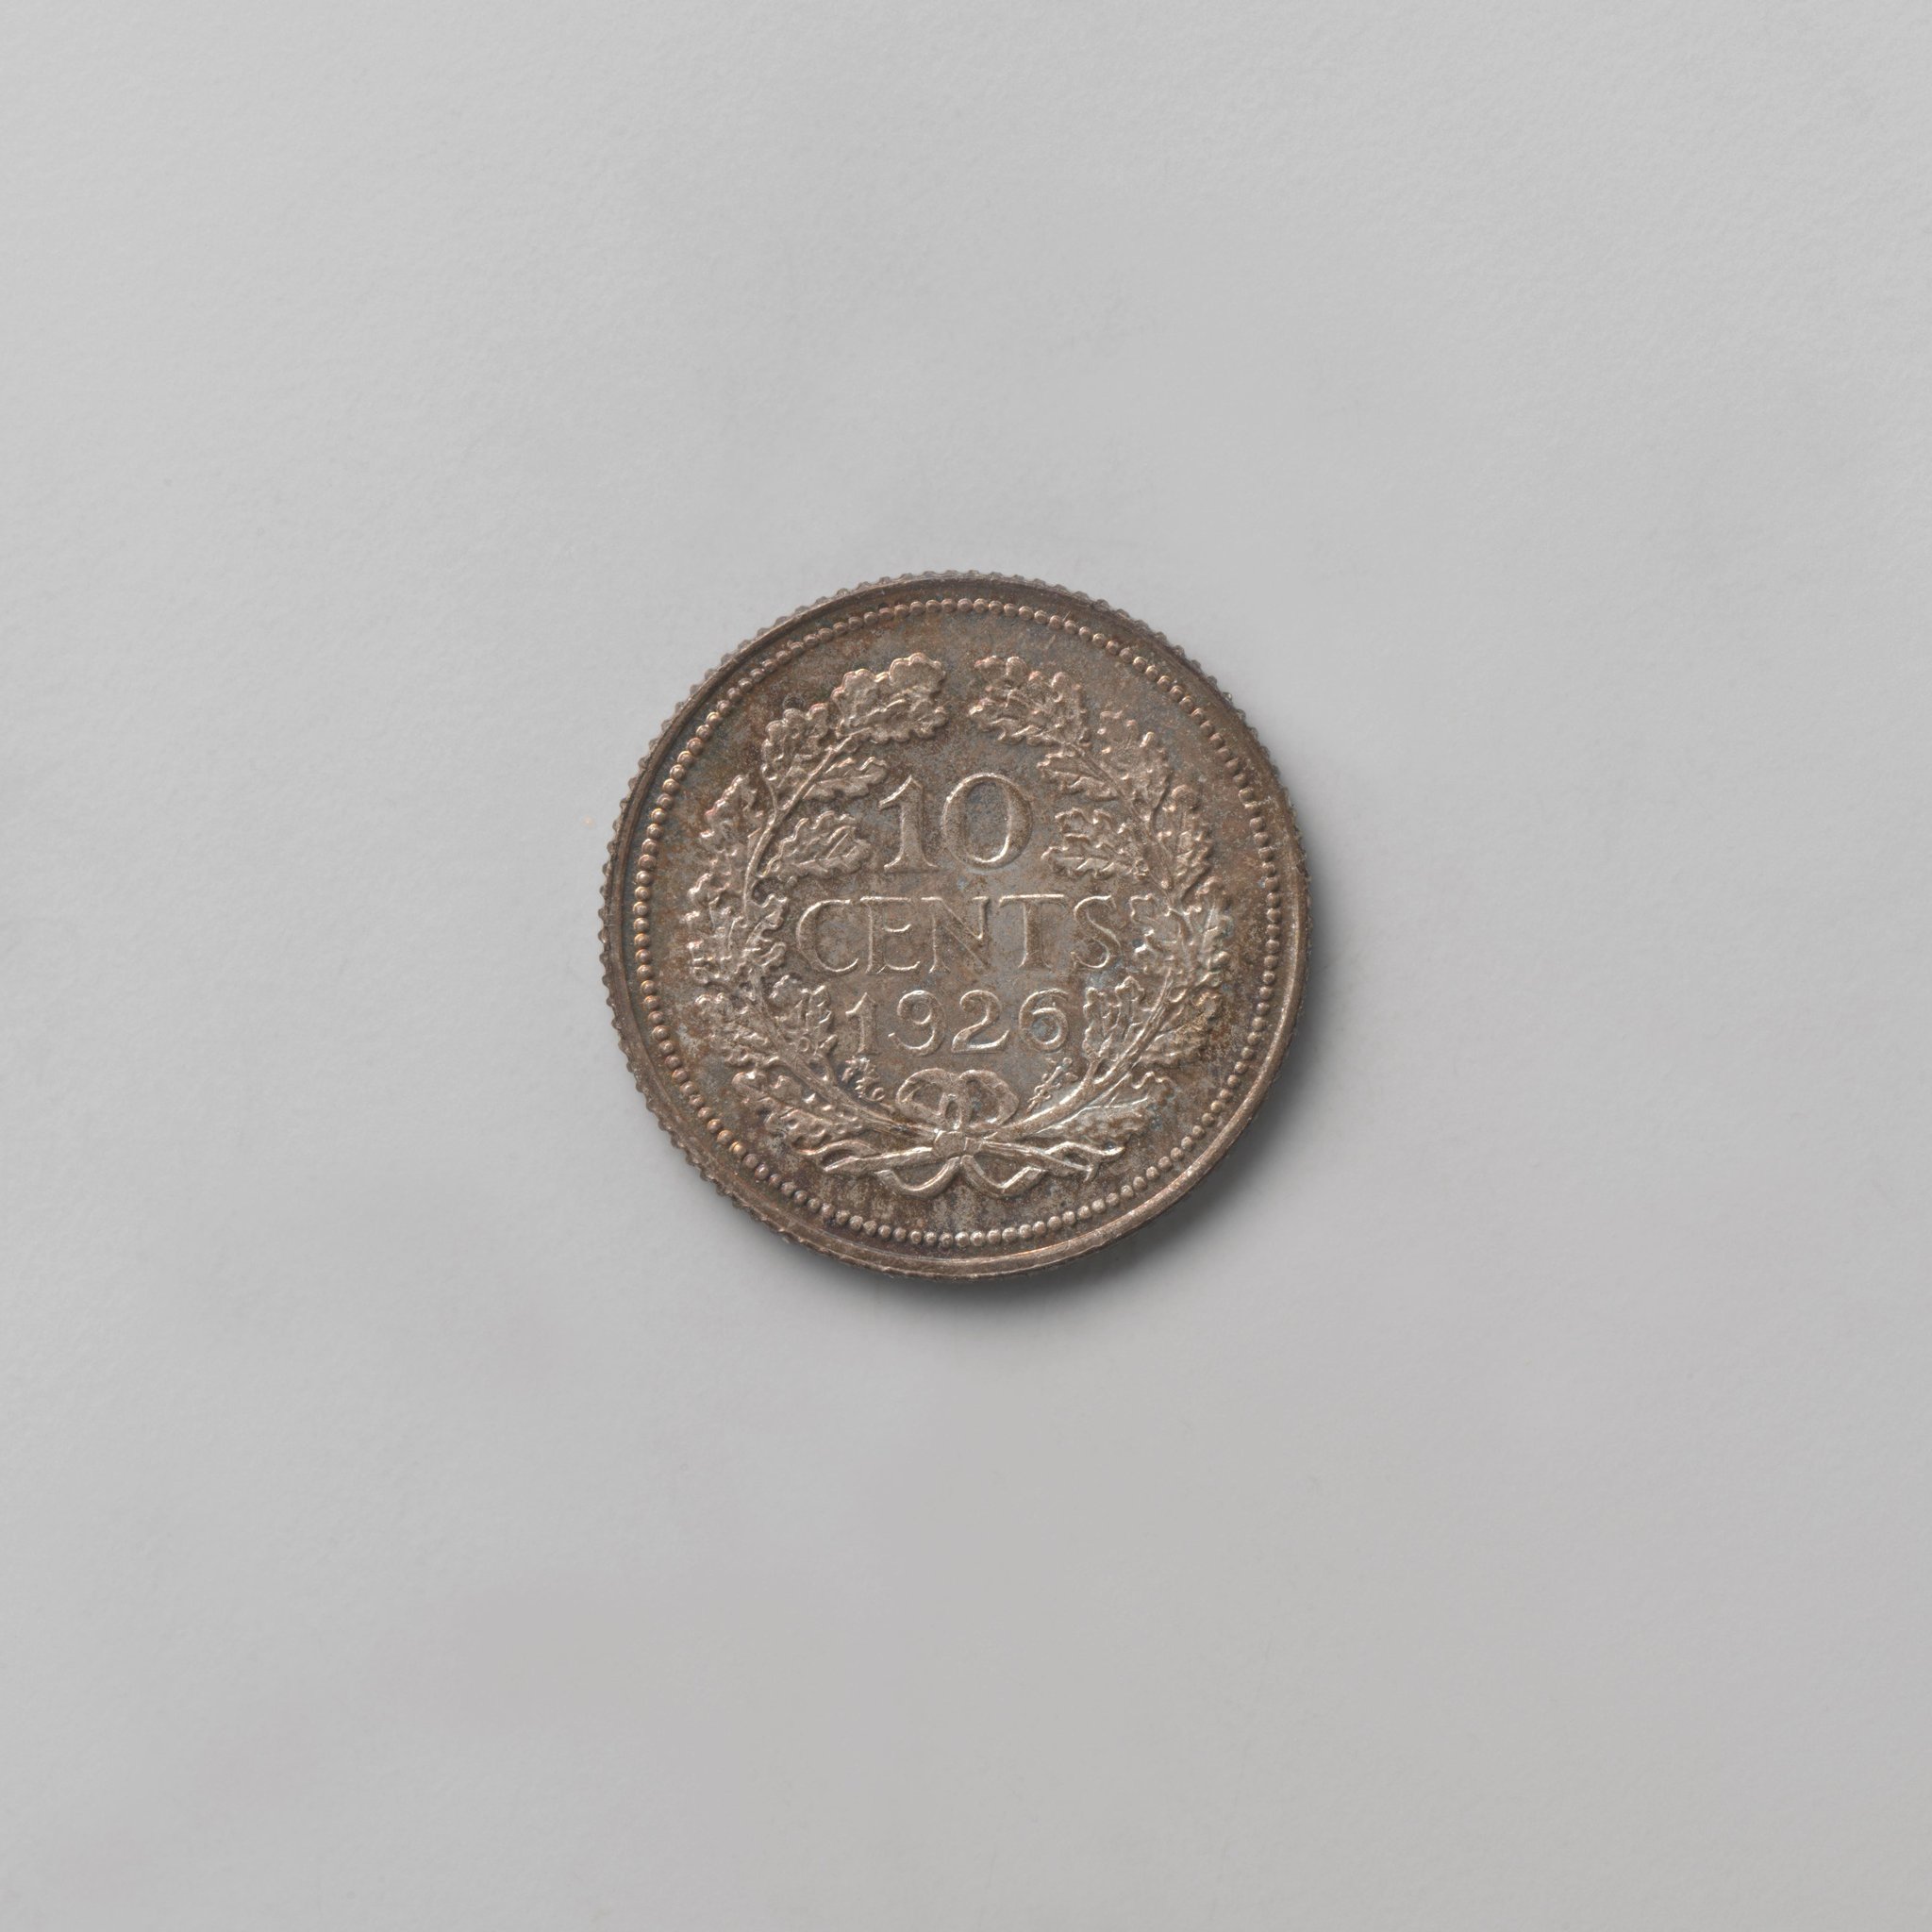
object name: coin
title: Nederland,10 cent,1926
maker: wilhelmina of the netherlands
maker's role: print maker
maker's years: 1880-1962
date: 1926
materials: silver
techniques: striking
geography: utrecht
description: Zilveren munt. Voorzijde: hoofd naar links. Keerzijde: binnen twee samengebonden eiketakken waarde-aanduiding 10 cents en jaartal. Kartelrand.